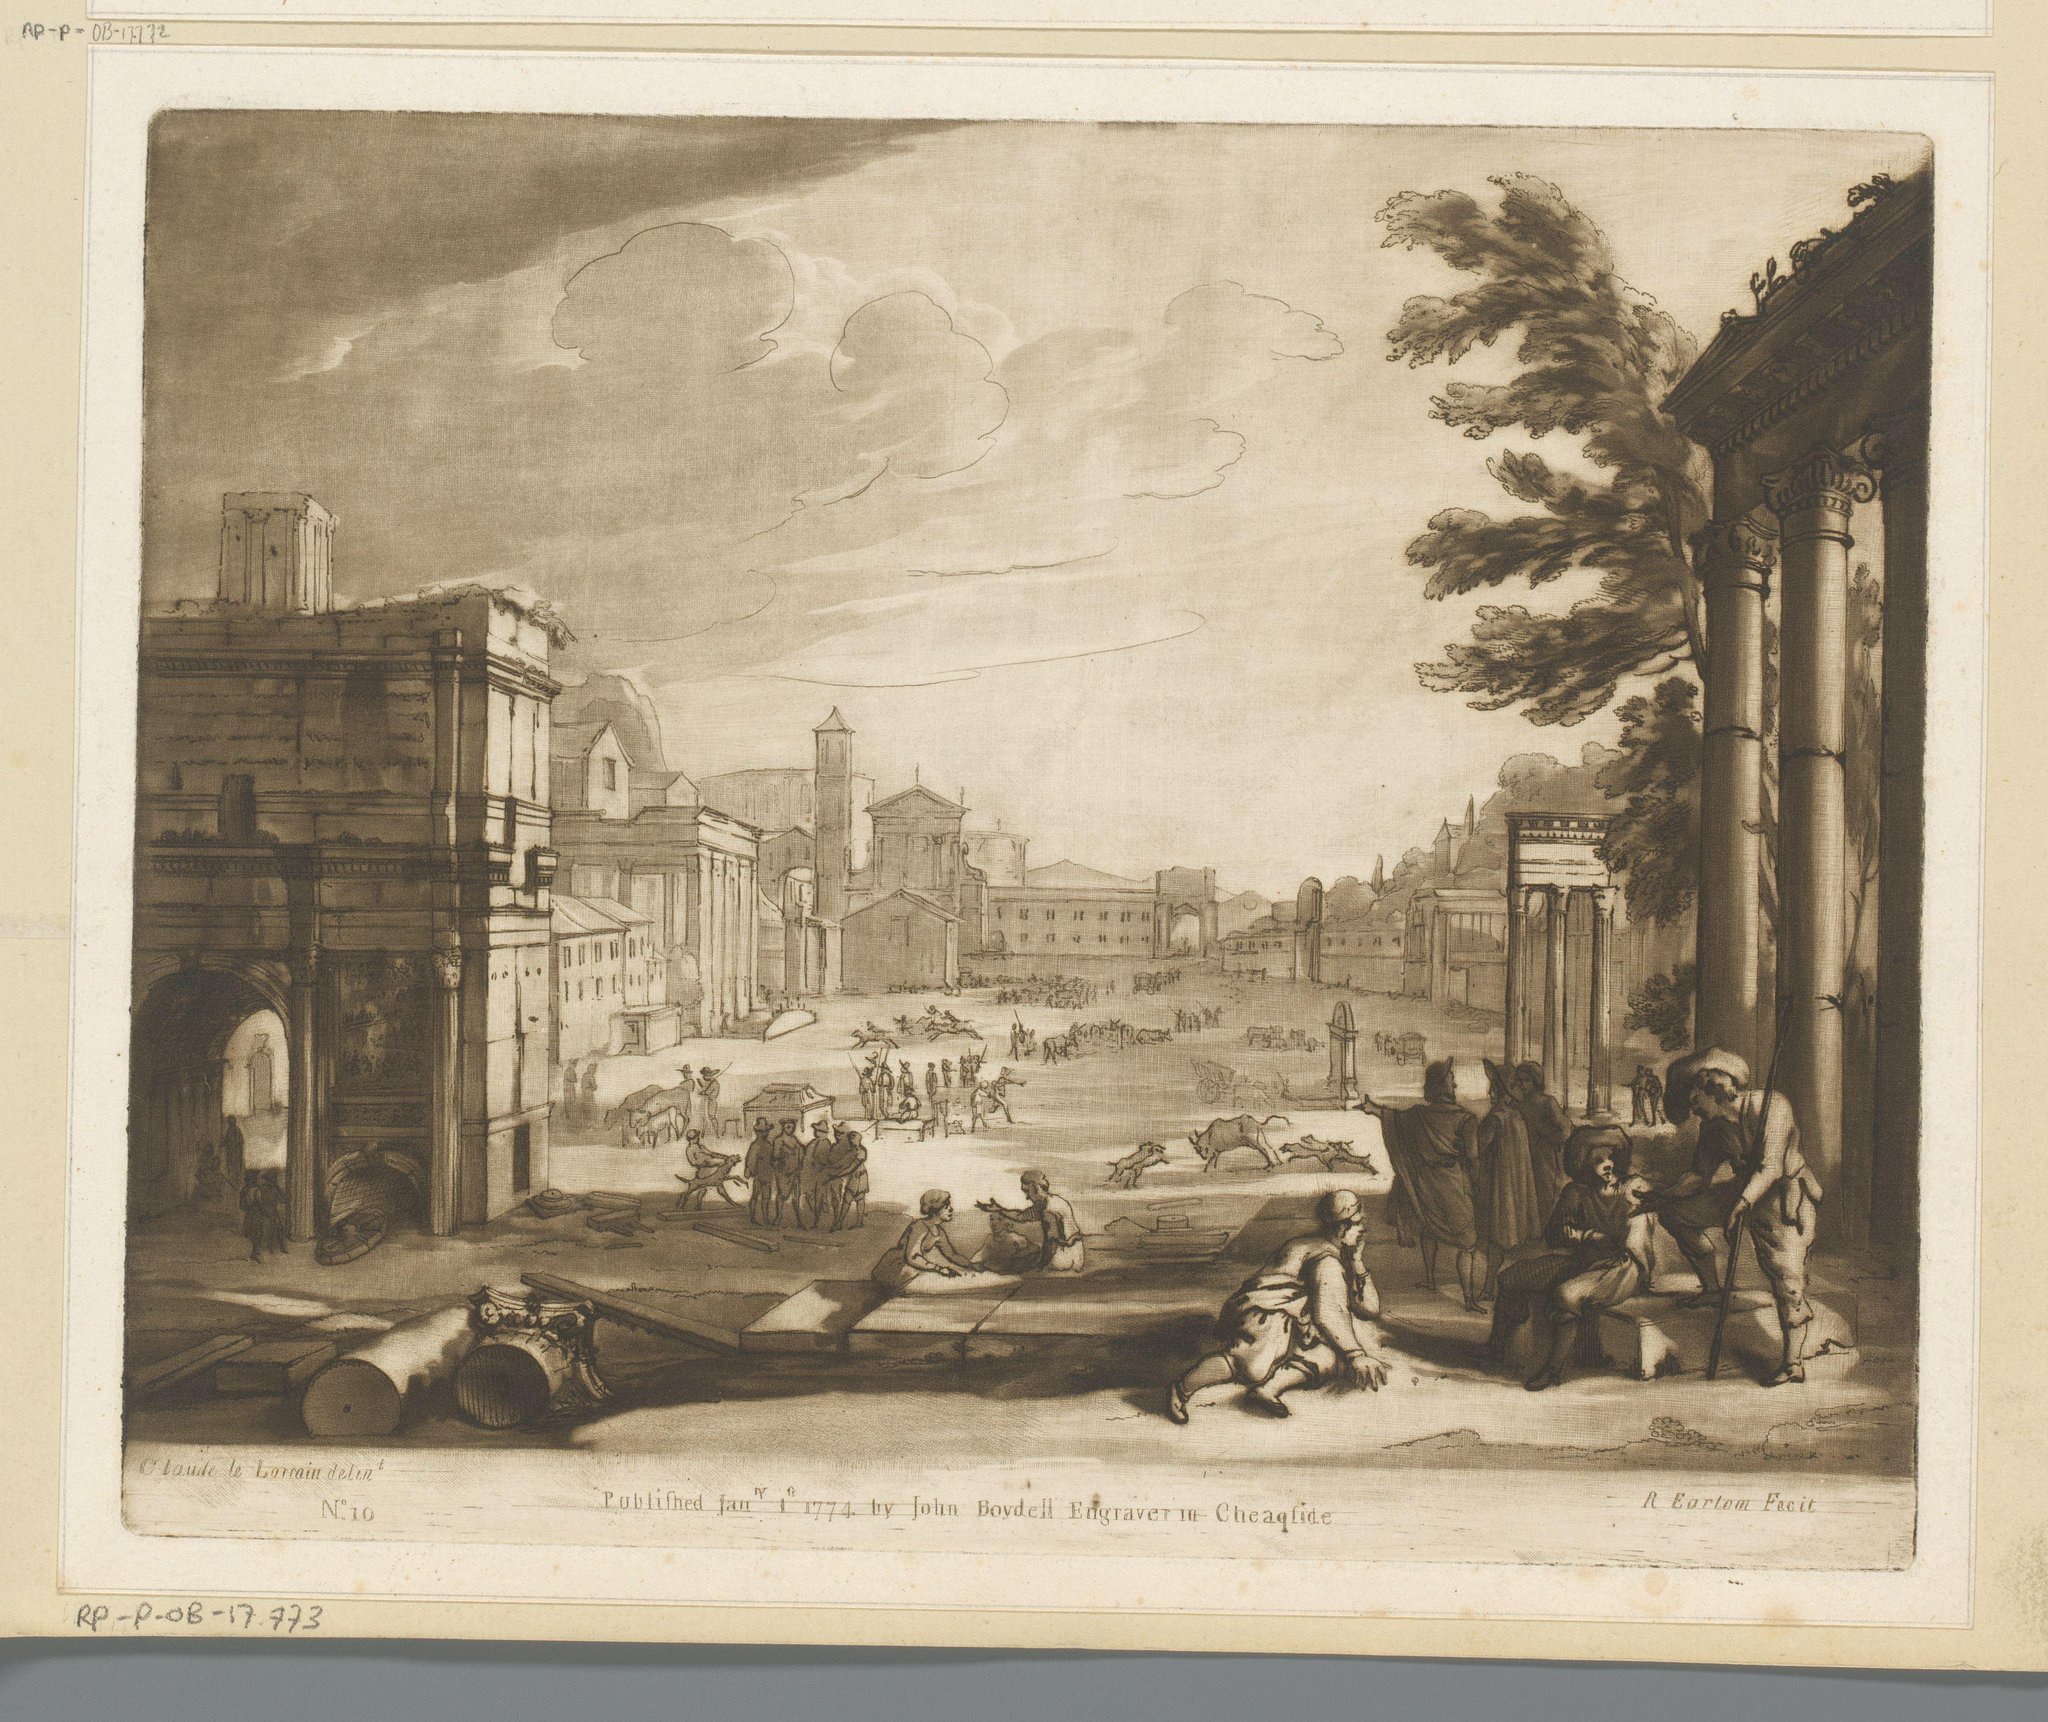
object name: print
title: Gezicht op het Forum Romanum te Rome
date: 1774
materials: paper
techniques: etching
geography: london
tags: triumphal arch, landscape with ruins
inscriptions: date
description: Vanaf 1774 publiceerde John Boydell tweehonderd prenten naar het tekeningenboek Liber Veritatis van Claude Lorrain, in het bezit van de hertogen van Cavendish. Deze werden vanaf 1777 in twee volumes gebundeld uitgegeven.